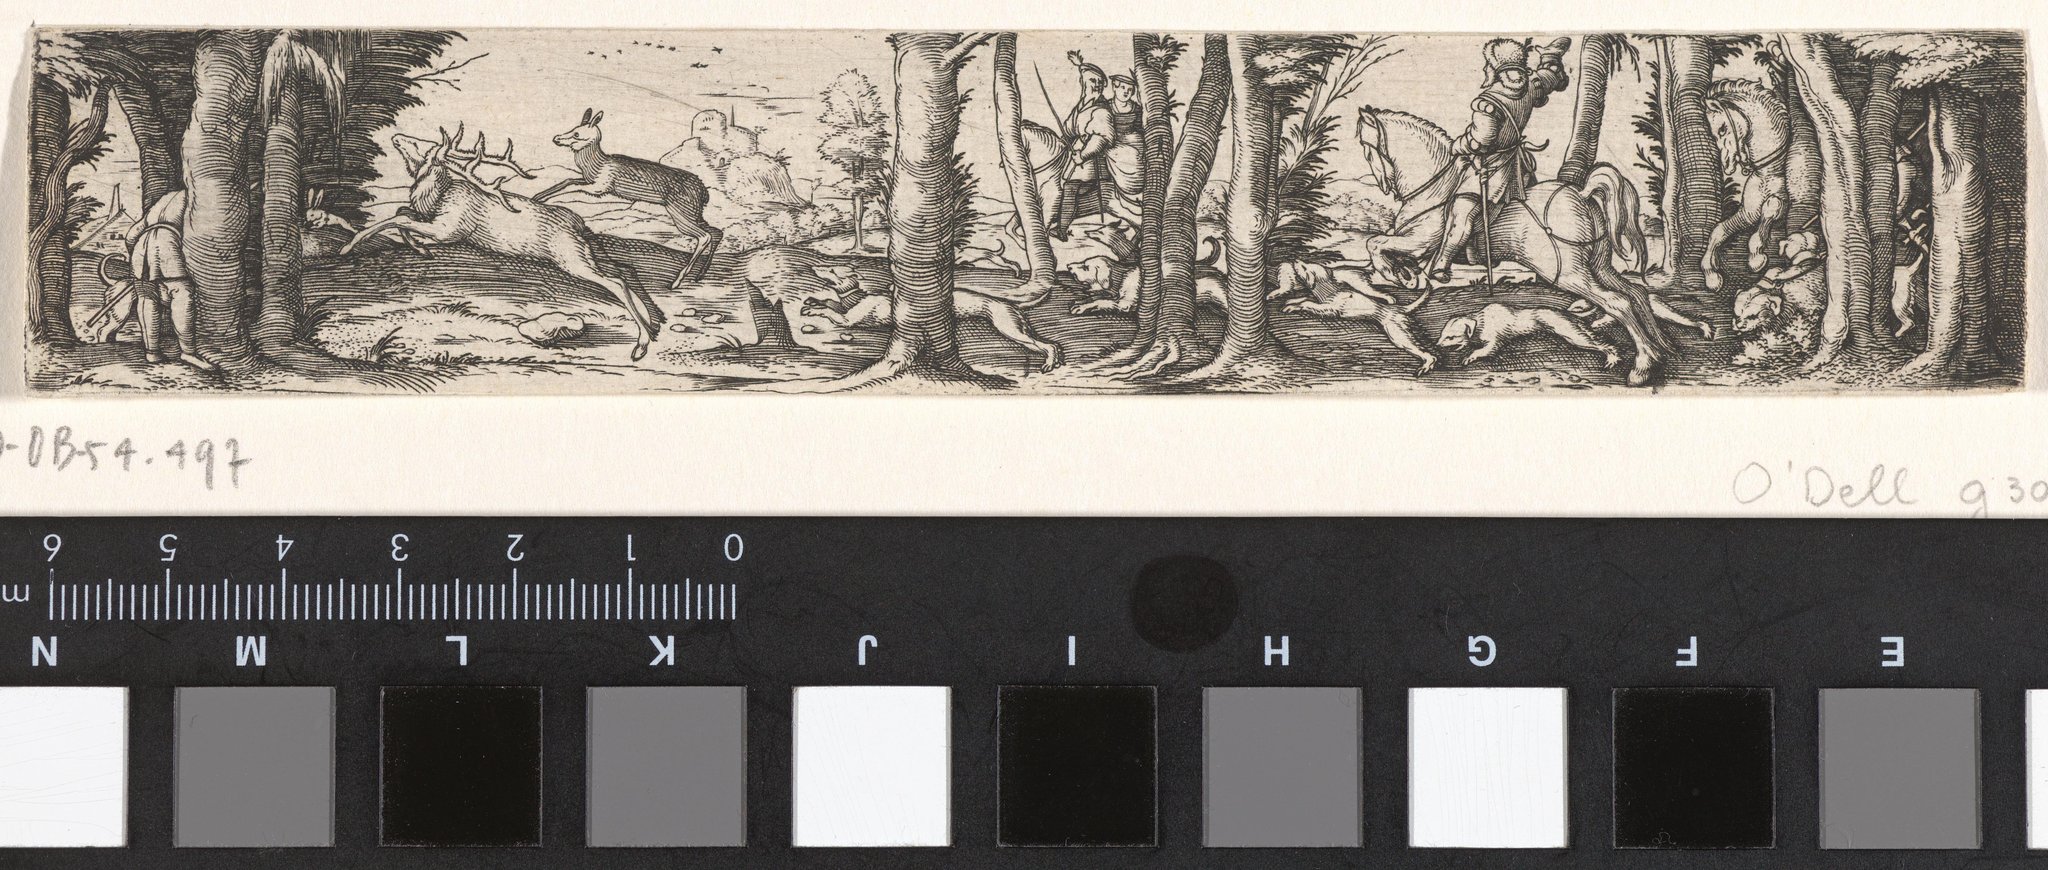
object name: print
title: Hertenjacht met links achter bomen een huis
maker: virgilius solis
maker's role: draughtsman, print maker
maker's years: 1514-1562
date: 1524-1562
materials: paper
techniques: engraving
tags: stag-hunting